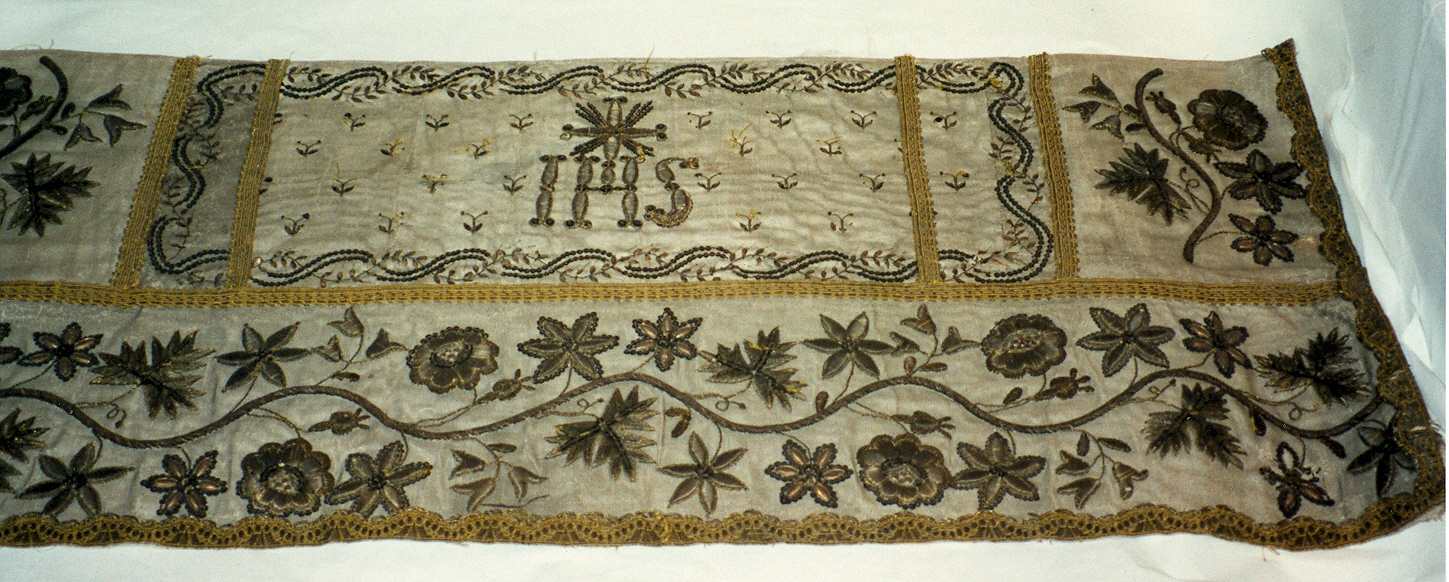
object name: altar frontal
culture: french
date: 1801-1900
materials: cotton, metal, silk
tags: flowers